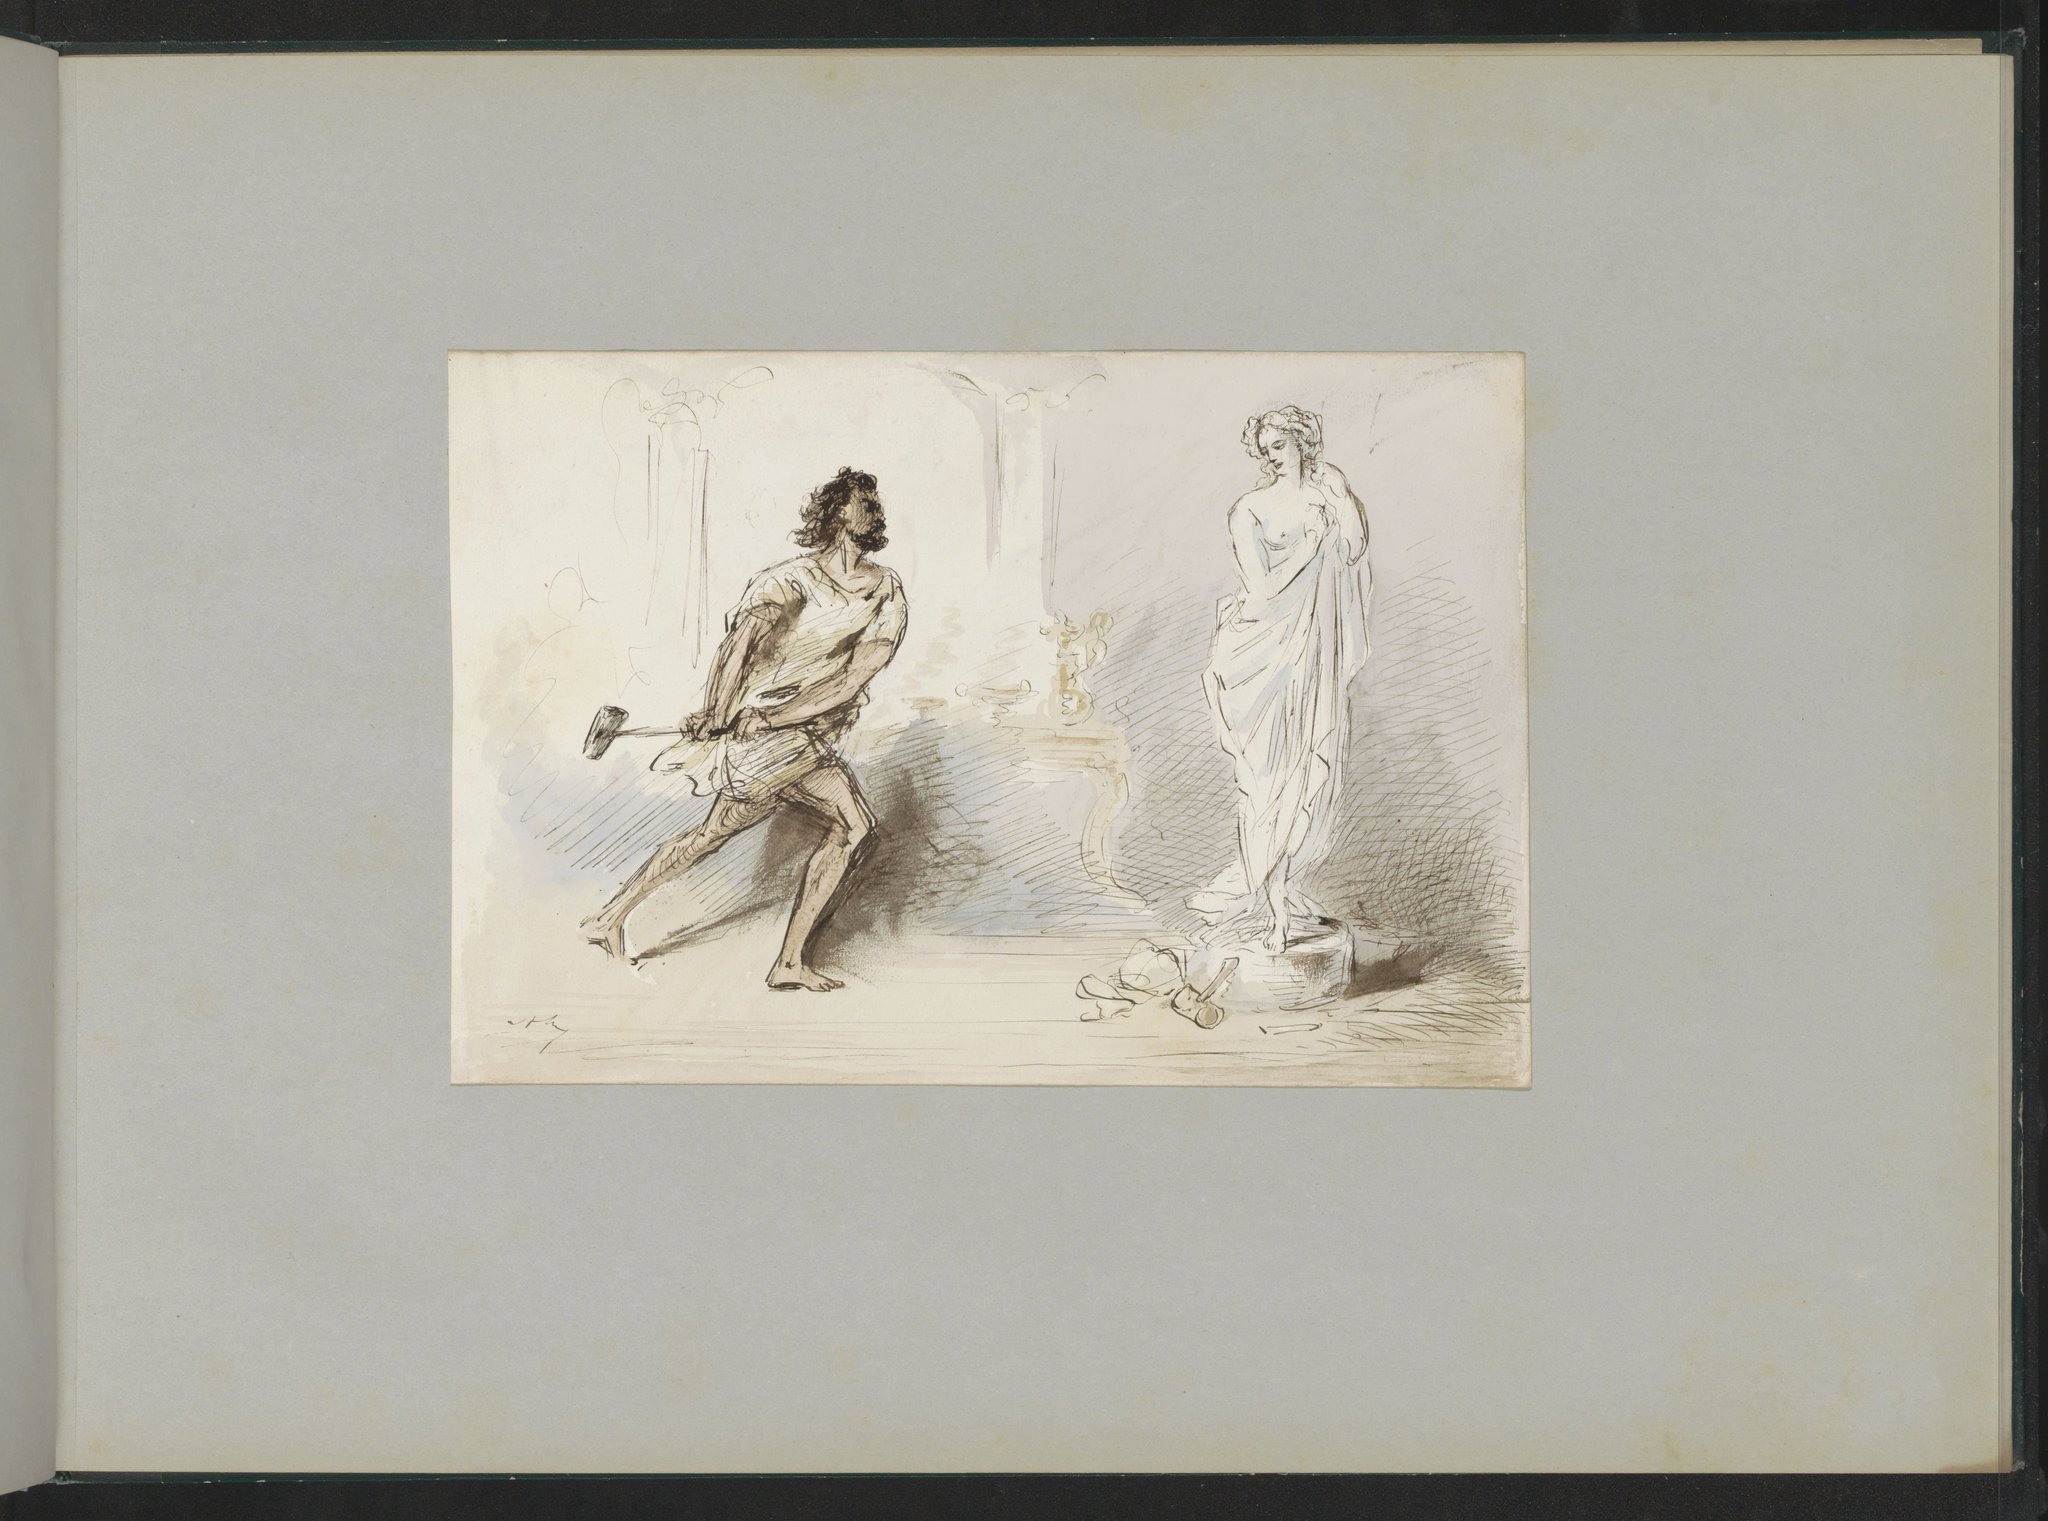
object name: drawing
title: Pygmalion en Galatea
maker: alexander ver huell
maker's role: draughtsman, print maker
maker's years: 1822-1897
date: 1854-1887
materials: ink, paper, watercolor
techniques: brush, pen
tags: pygmalion falls in love with the statue he is carving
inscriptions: signature: ‘Avh’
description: Pygmalion, gekleed in een tuniek, loopt met een houten hamer richting de sculptuur van Galatea. Recto van de tekening op blad 9 van een album met 35 tekeningen.